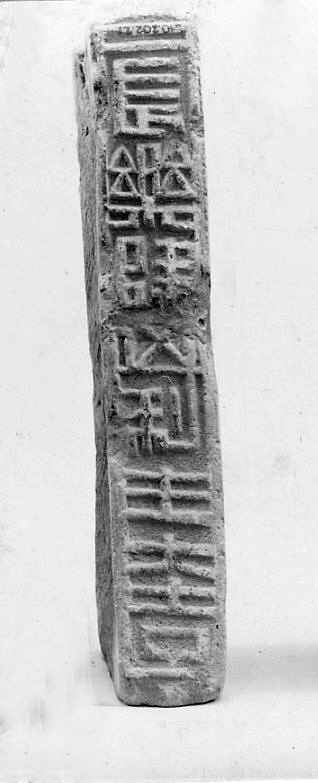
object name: tile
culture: chinese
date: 221 BCE-220 CE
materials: earthenware